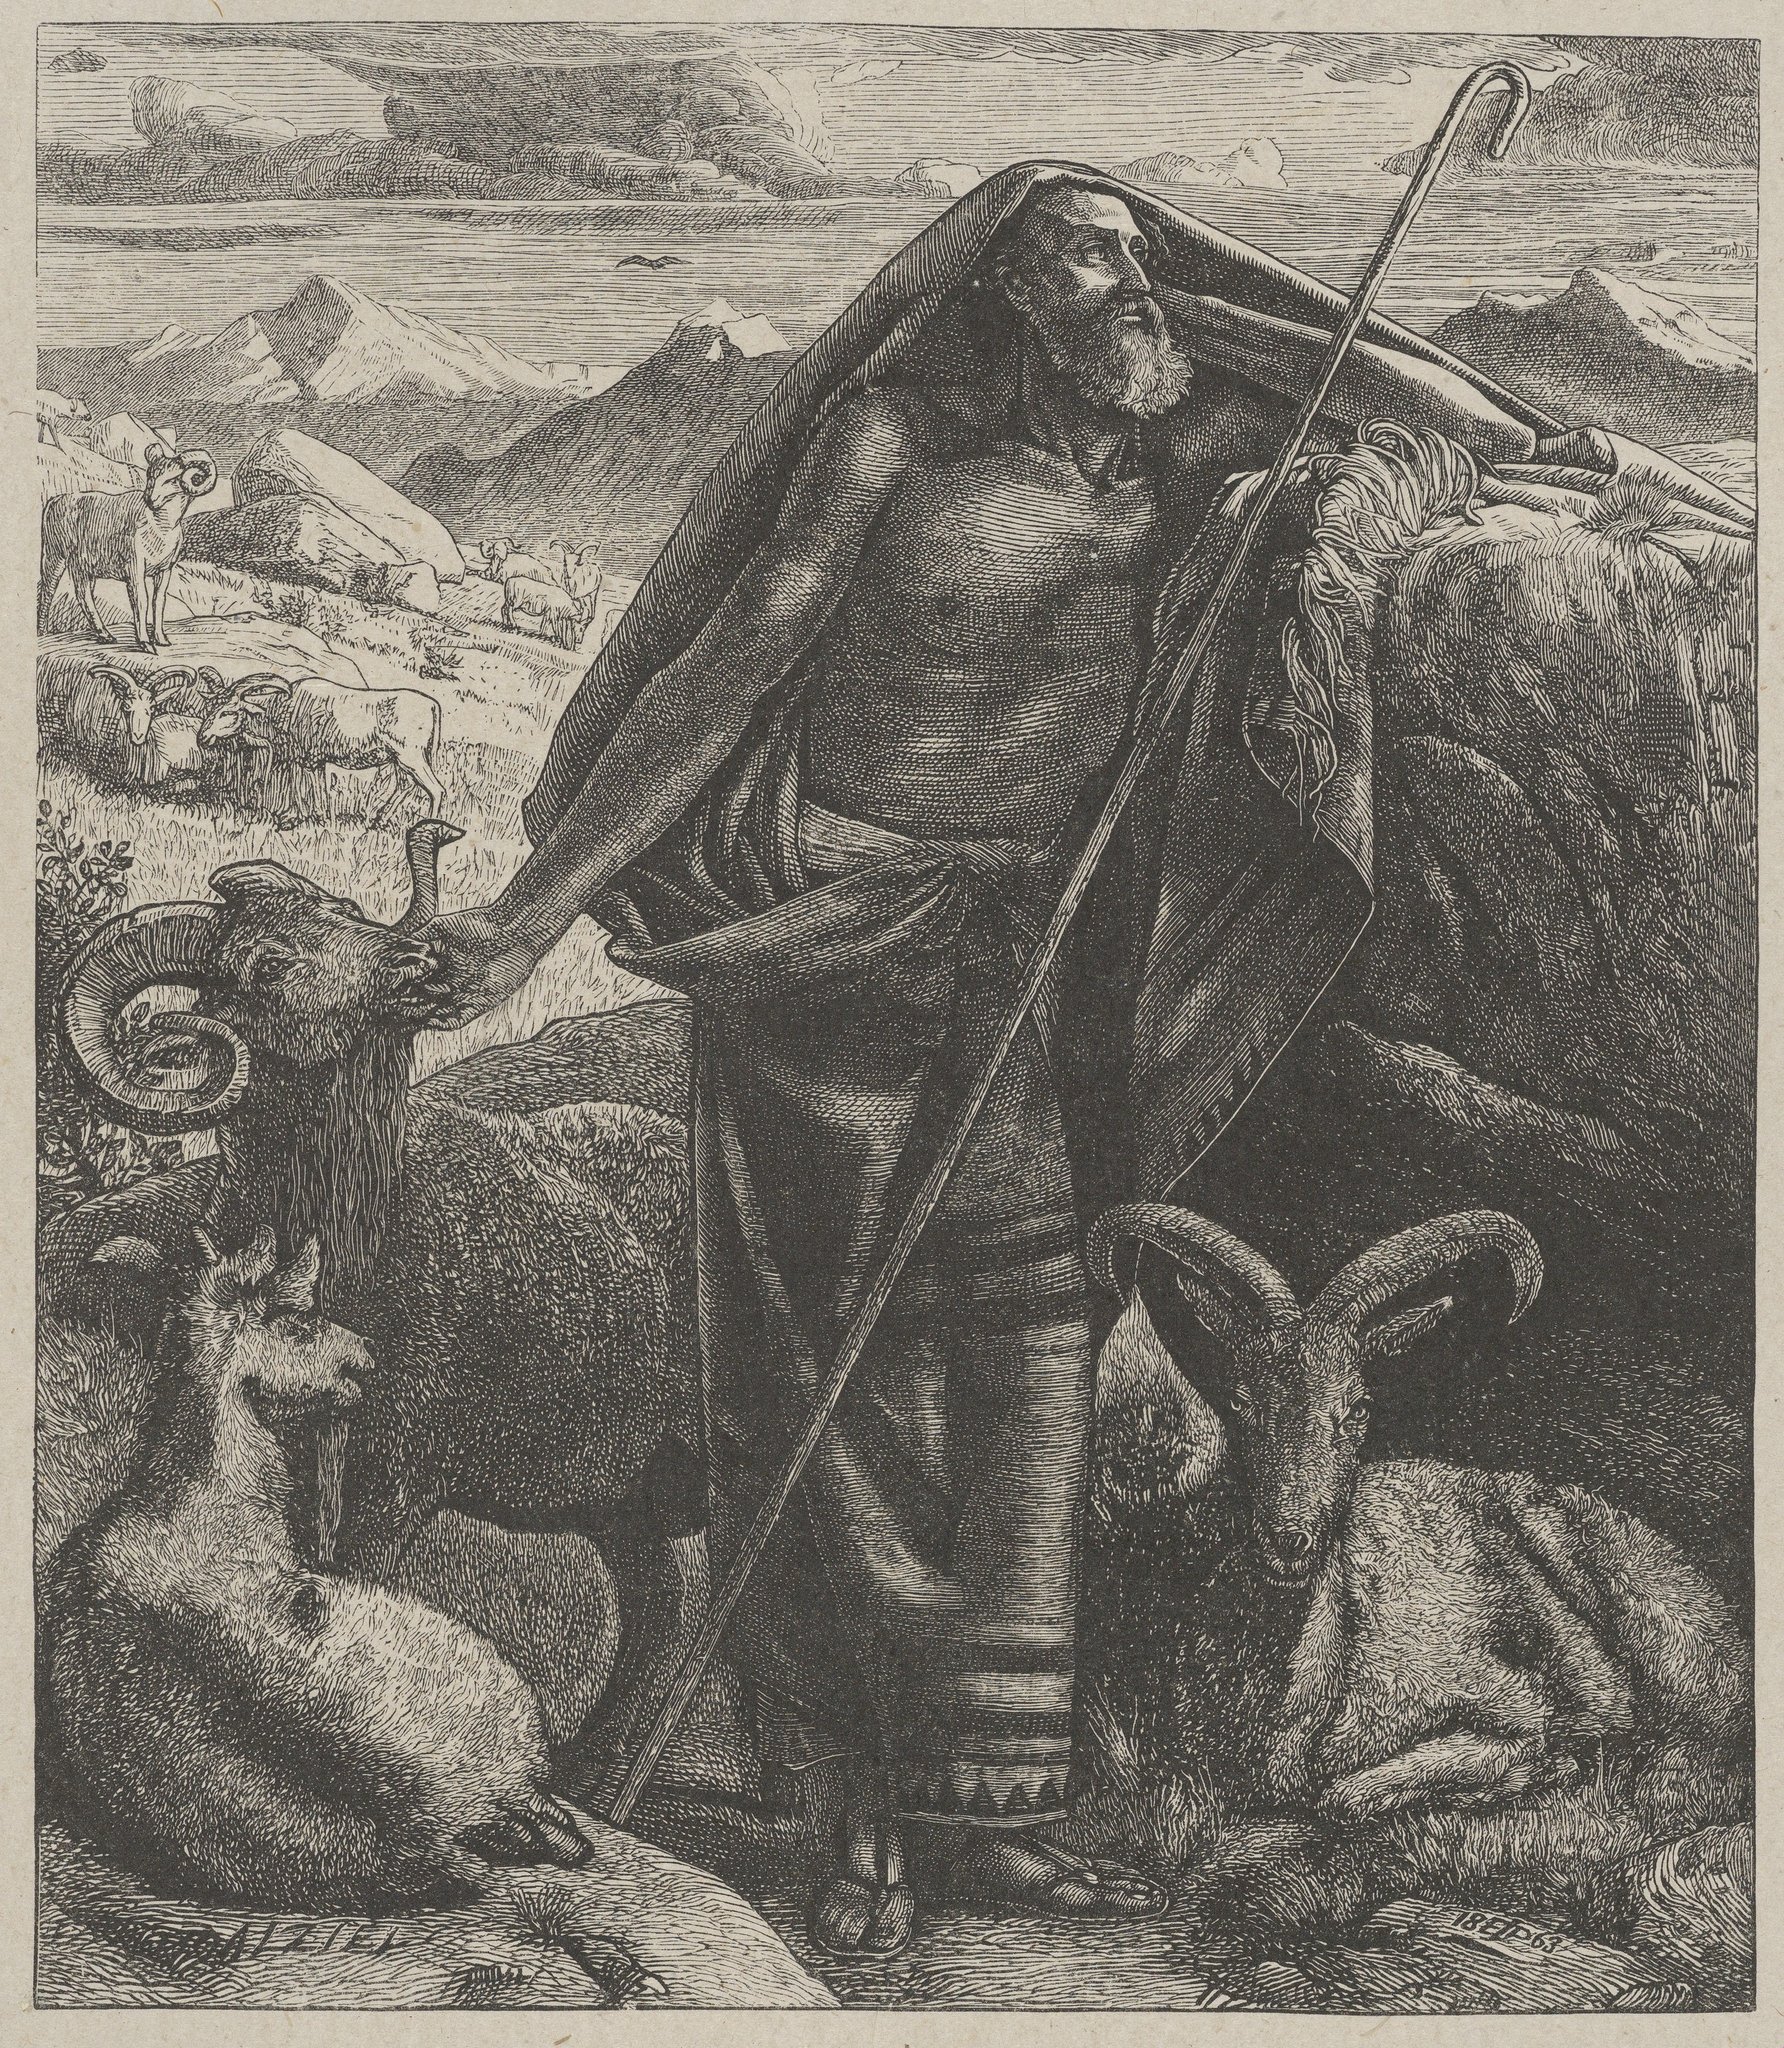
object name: print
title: Moses Keeping Jethro's Sheep, from "Dalziels' Bible Gallery"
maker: sir edward john poynter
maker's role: artist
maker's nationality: british, born france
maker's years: 1836-1919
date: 1863-1881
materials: paper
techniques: engraving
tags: sheep,moses